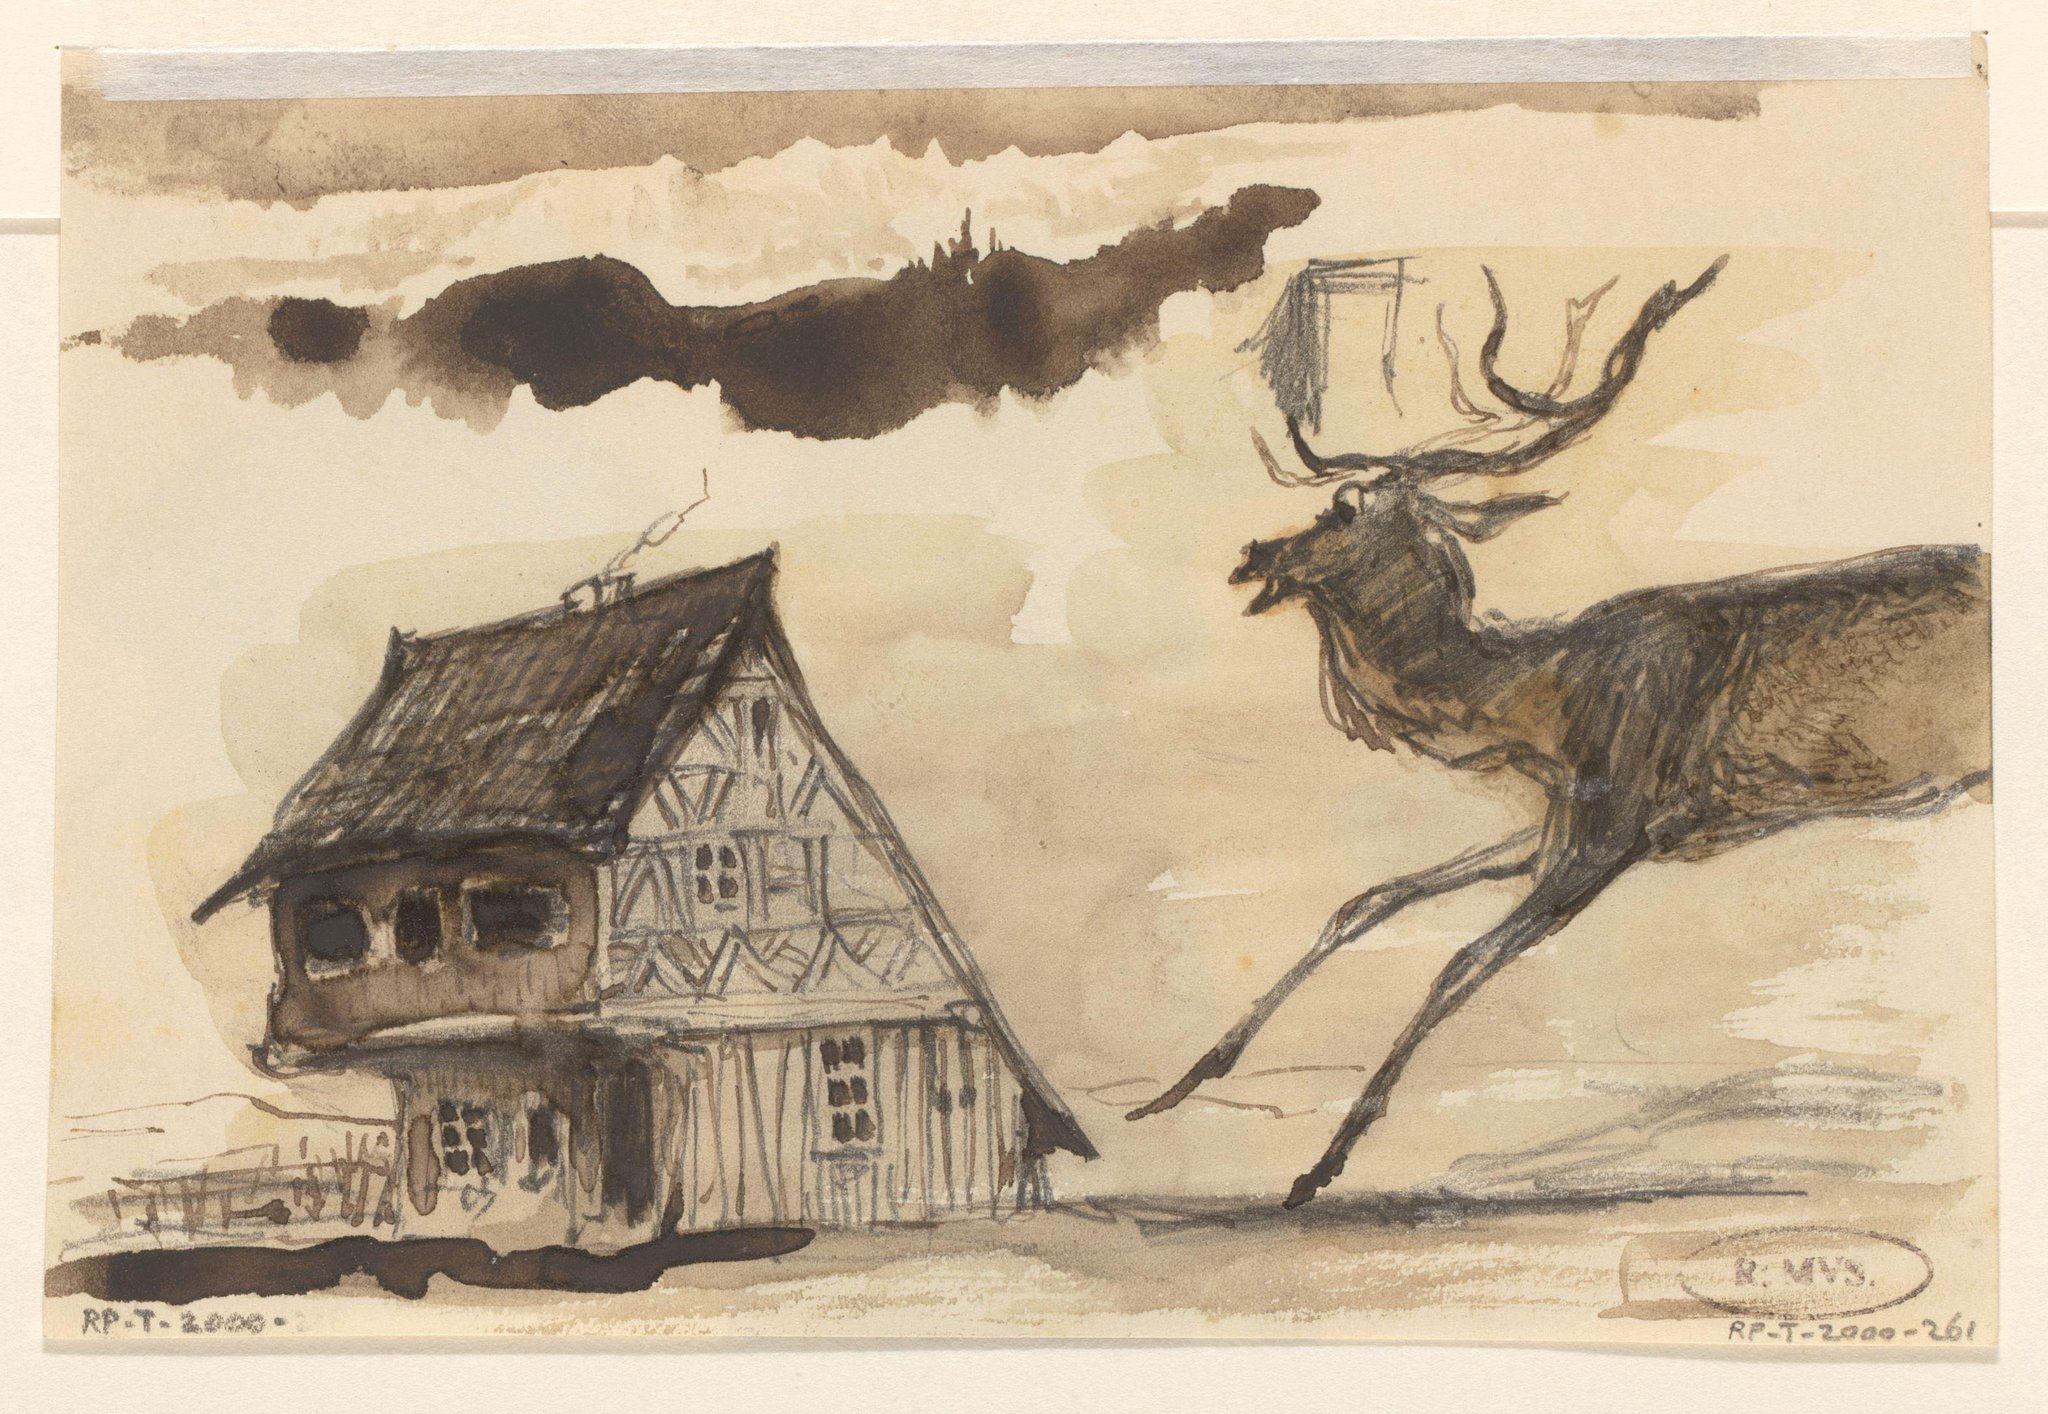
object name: drawing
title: Huis en hert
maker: johannes tavenraat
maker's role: draughtsman, painter, print maker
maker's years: 1809-1881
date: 1840-1880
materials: ink, paper, pencil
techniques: brush, pen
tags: hoofed animals: deer, rural housing, e.g. country-house, villa, cottage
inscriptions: collector's mark: Lugt 2228